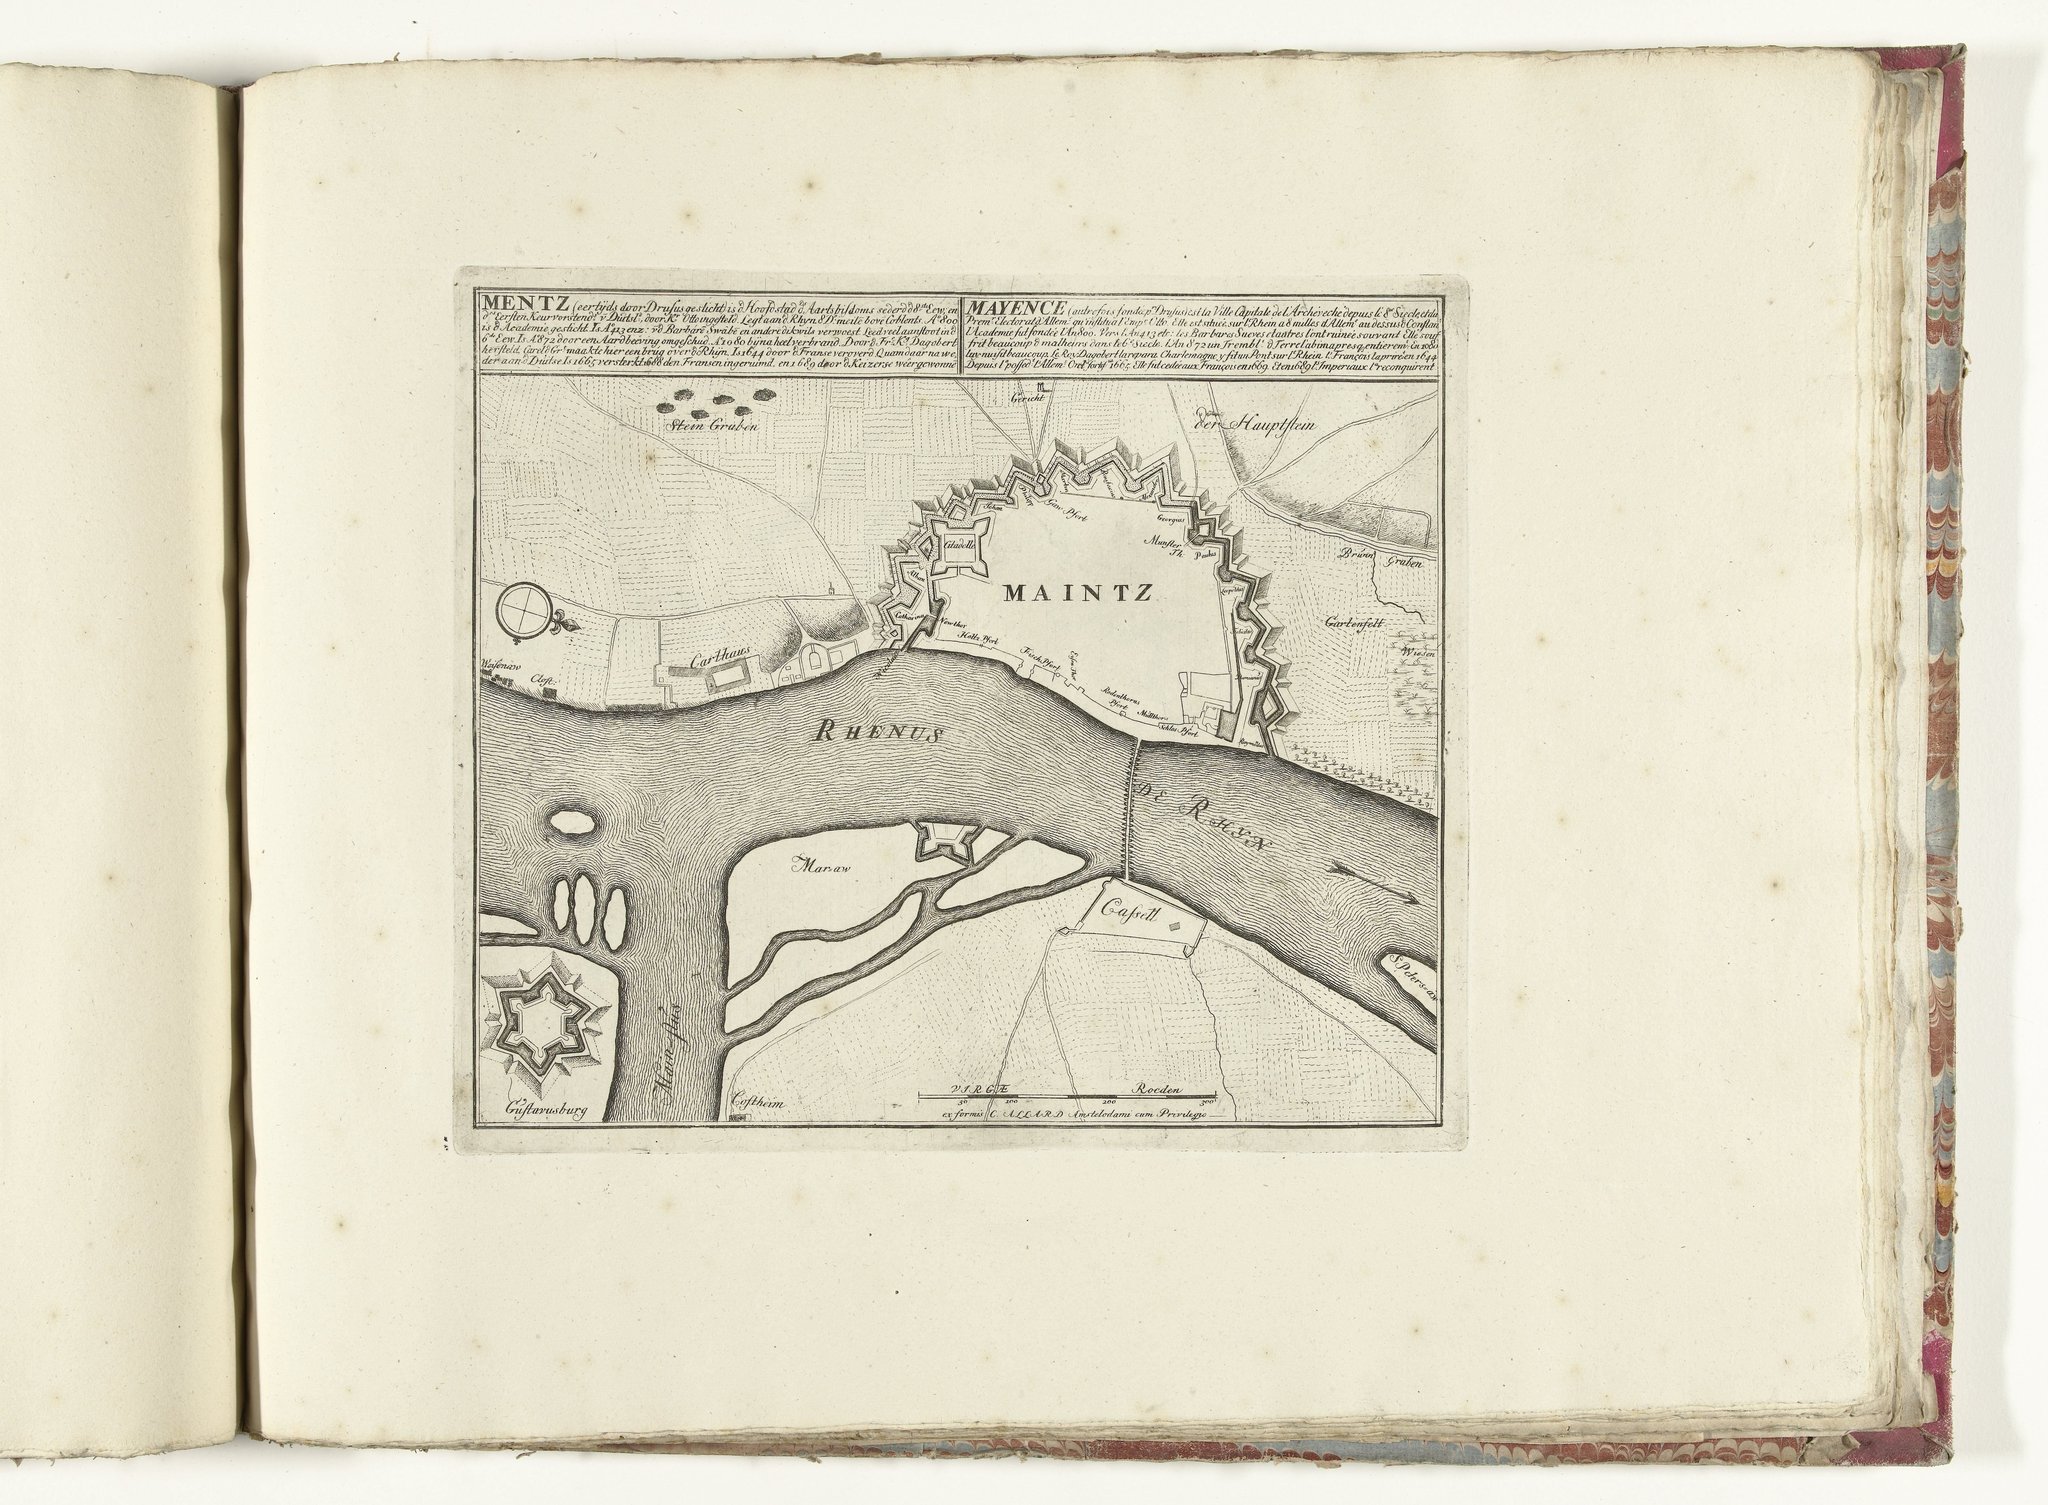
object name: map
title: Mentz (...) is d'hoofdstad d'aartsbisdoms (...)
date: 1701-1714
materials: paper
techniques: etching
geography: amsterdam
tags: maps of cities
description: Gekopieerd naar de Franse prenten in: Nicolas de Fer, Les forces de l'Europe, ou description des principales villes, avec leurs fortifications : dessignées par les meilleurs ingenieurs, particulierement celles ... de la France, dont les plans ont esté levez par M. de Vauban, Nicolas de Fer, Parijs 1693-1696, of andere voorbeelden.